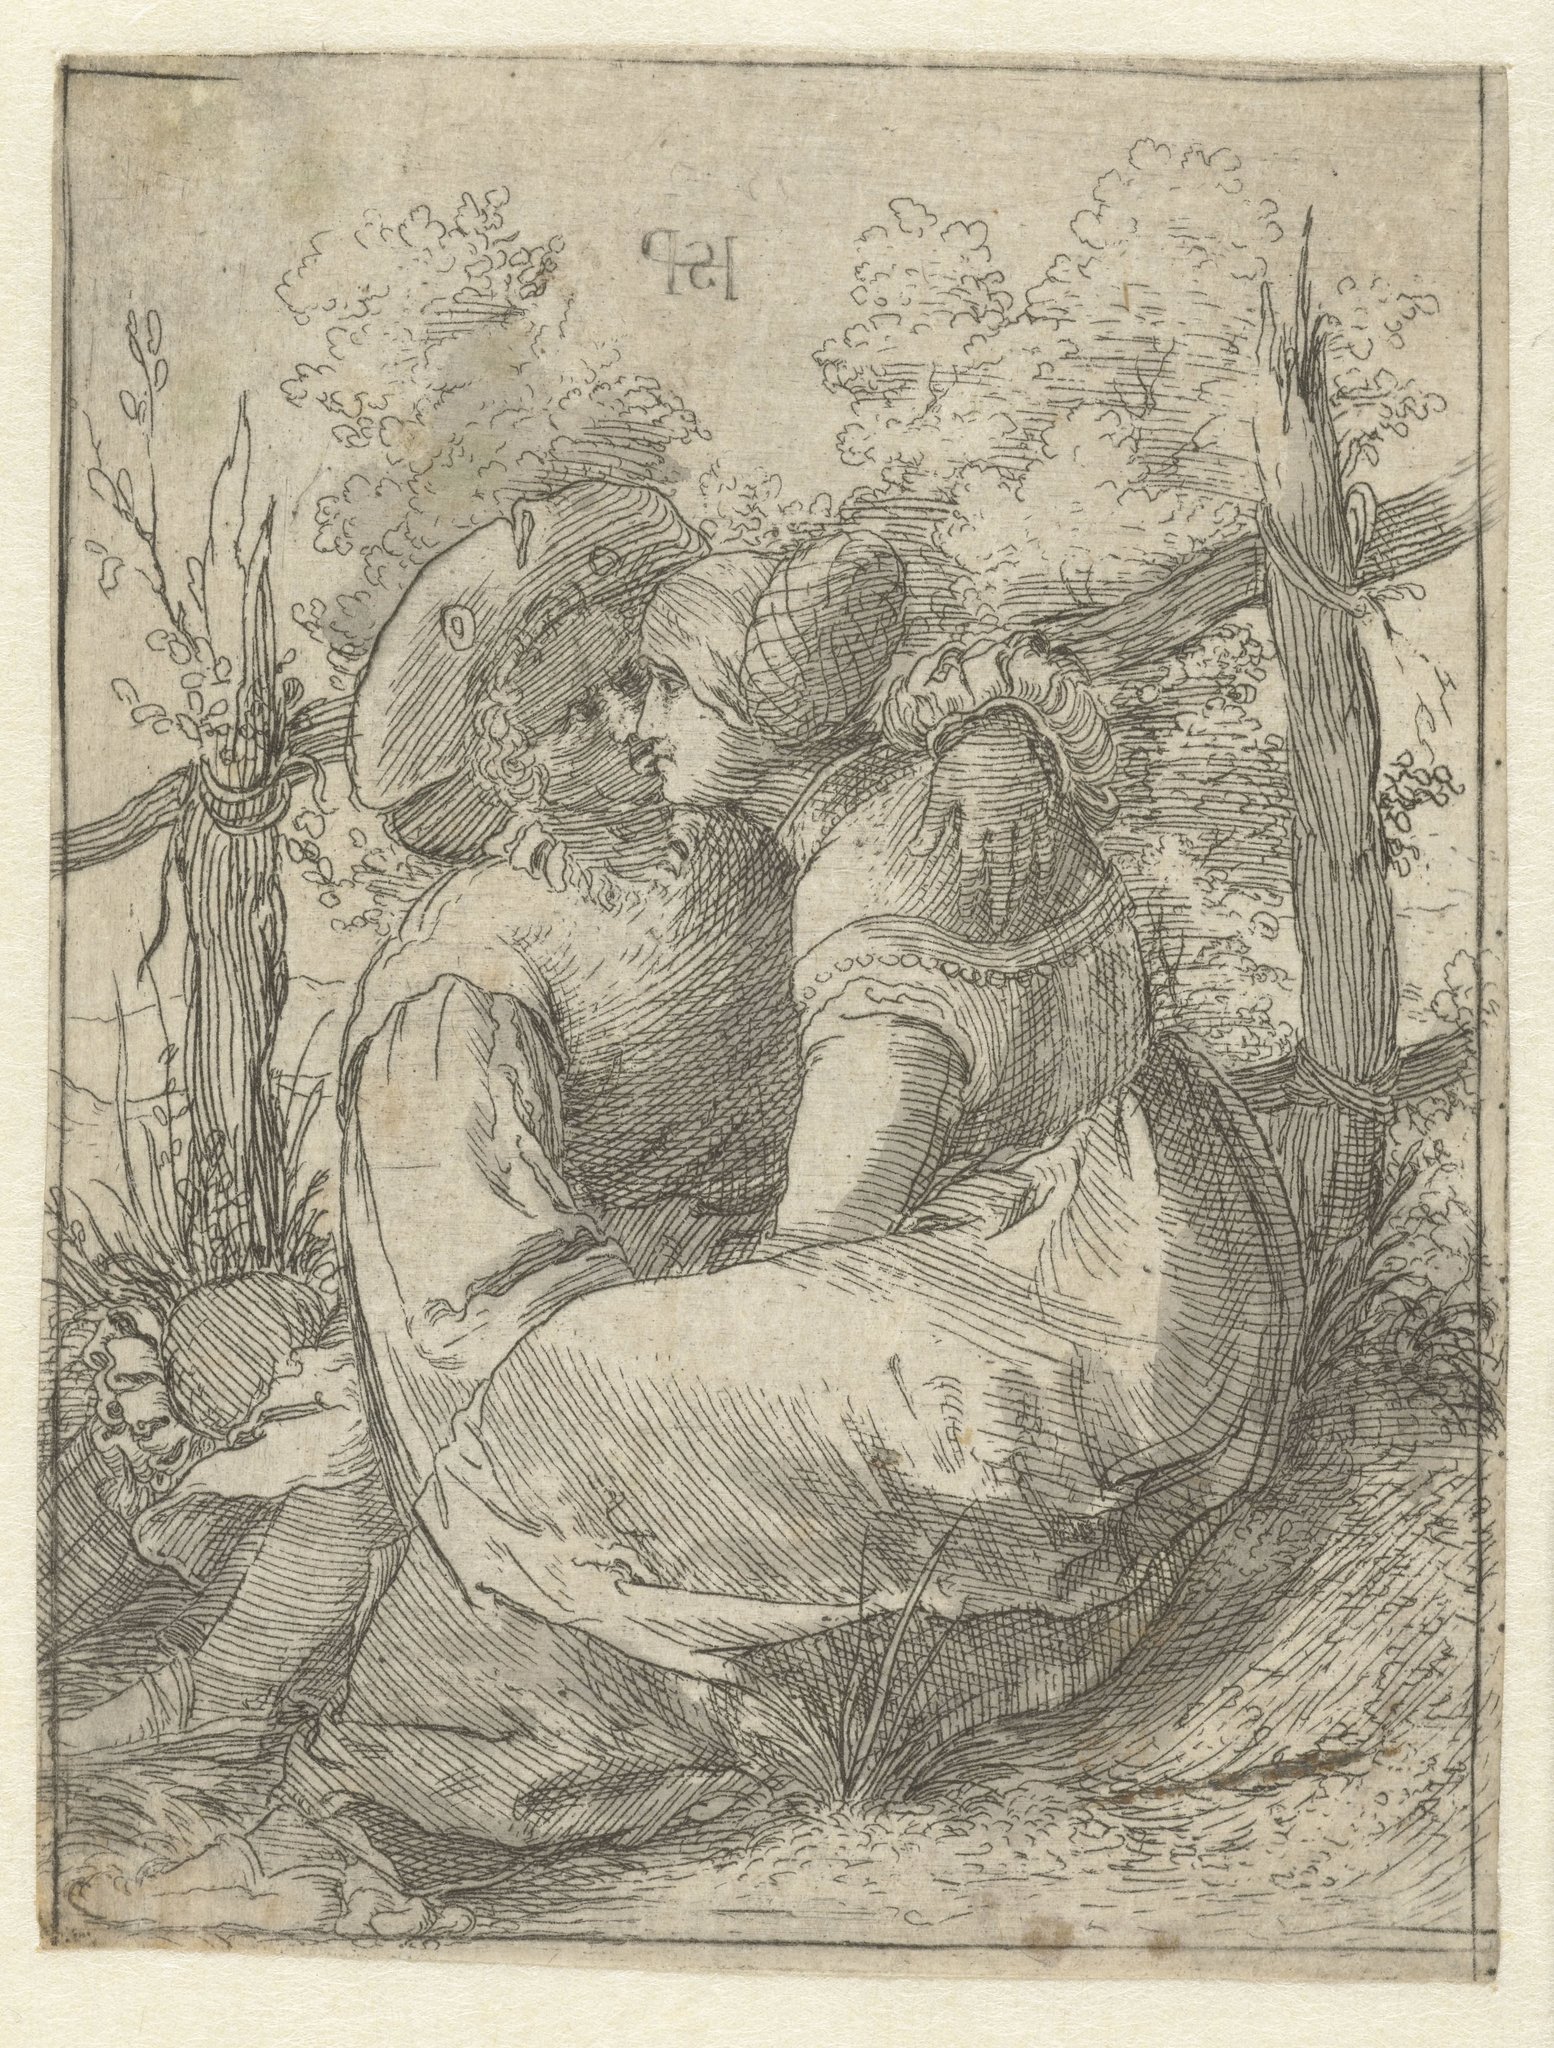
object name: print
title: Liefdespaar zittend voor een hek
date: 1522-1599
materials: paper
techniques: brush, etching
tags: embracing each other, kissing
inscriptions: collector's mark: Lugt 240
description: Kopie in spiegelbeeld naar prent van Hans Sebald Beham